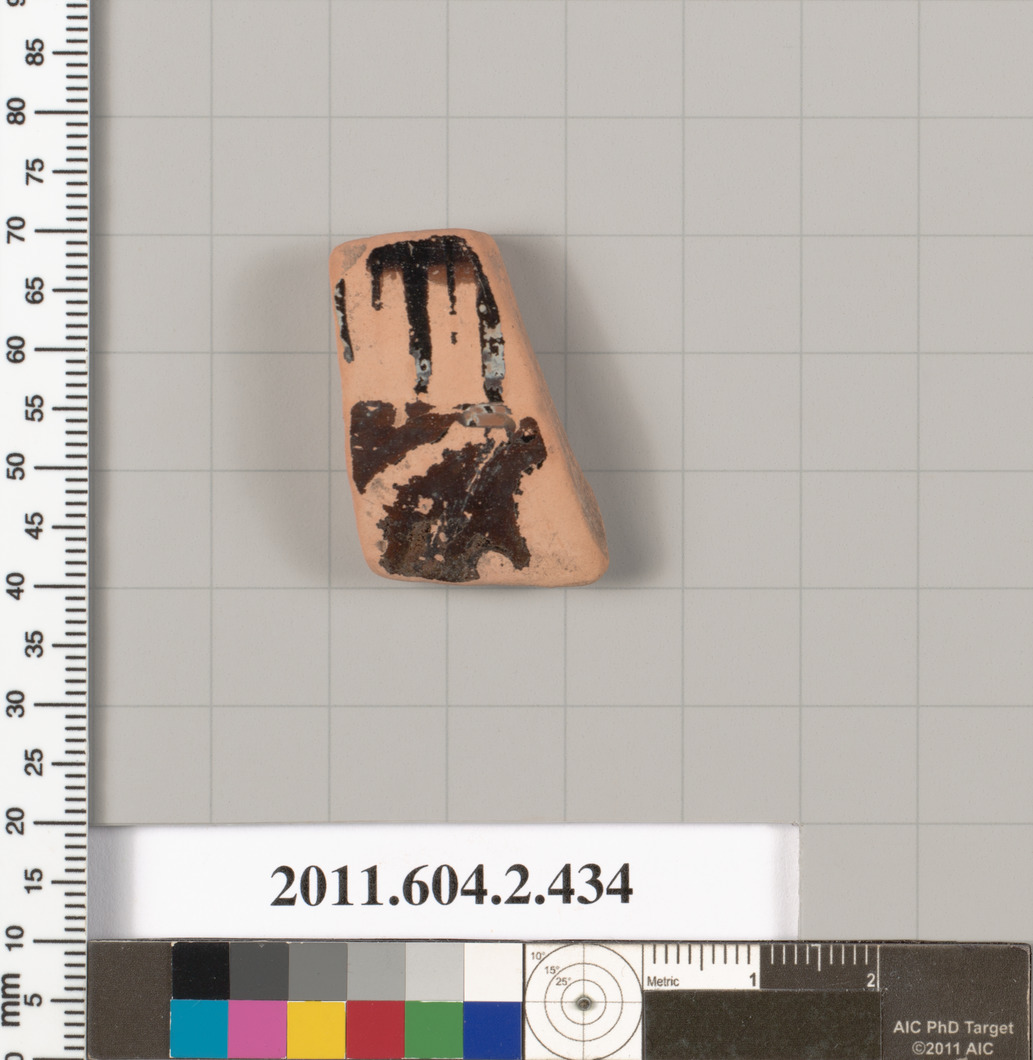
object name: column krater fragment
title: Terracotta fragment of a column-krater (bowl for mixing wine and water)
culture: greek, attic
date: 460-440 BCE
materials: terracotta